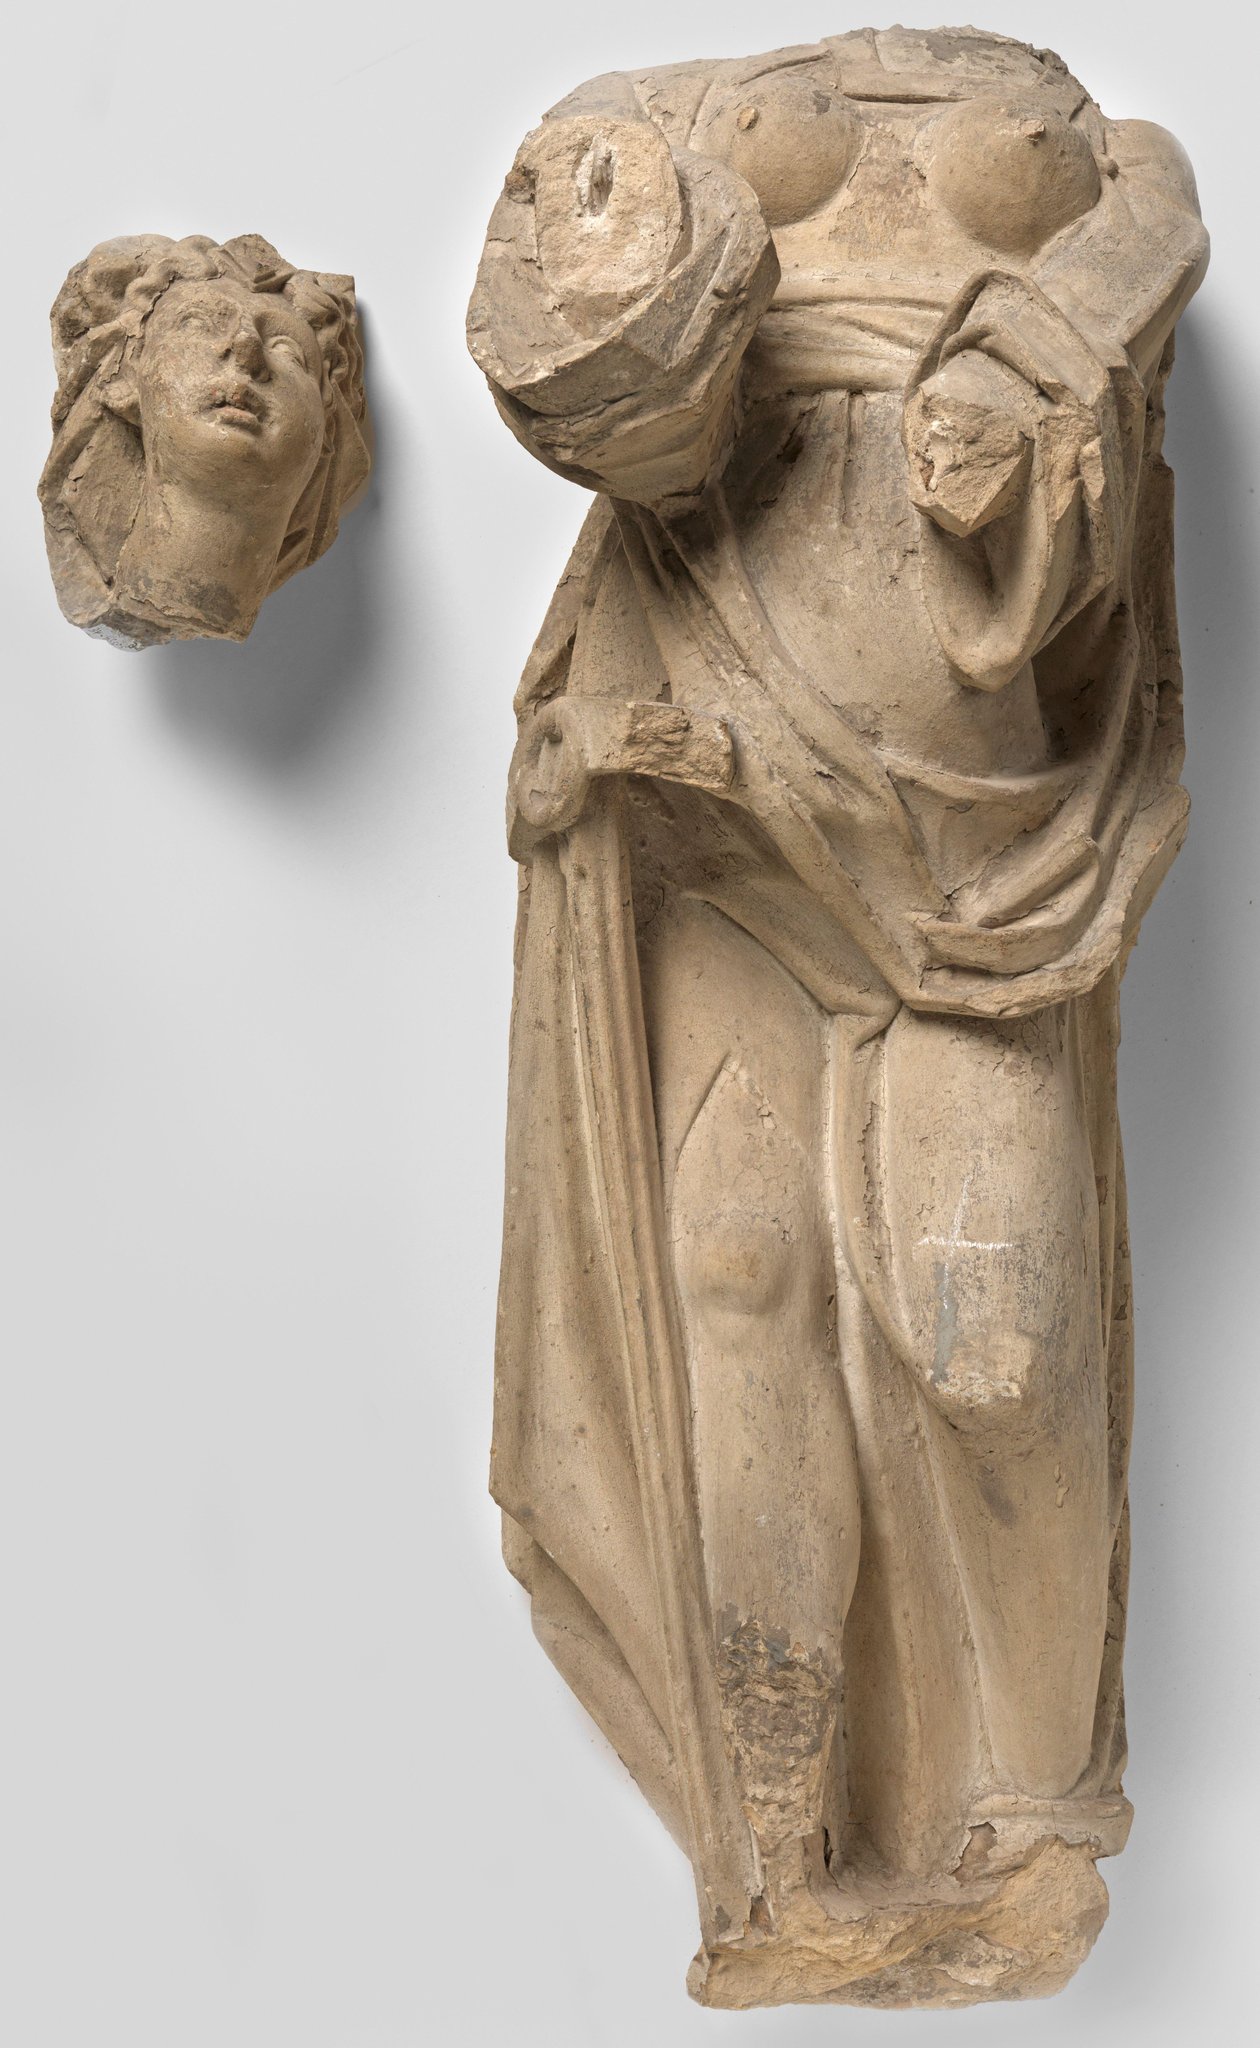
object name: sculpture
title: Hope, from the Facade of the Penninckshuis in Deventer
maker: Anonymous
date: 1588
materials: stone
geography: westphalia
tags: penninckhuis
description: Vrouw ten voeten uit staande, haar linkerbeen gebogen en haar rechterbeen steekt door de split van haar rok. Links van haar staat een anker. Het hoofd is afgebroken en wordt bij het beeld bewaard. Het beeld hoort bij zes beelden (BK-18757-A t/m BK-18757-F)